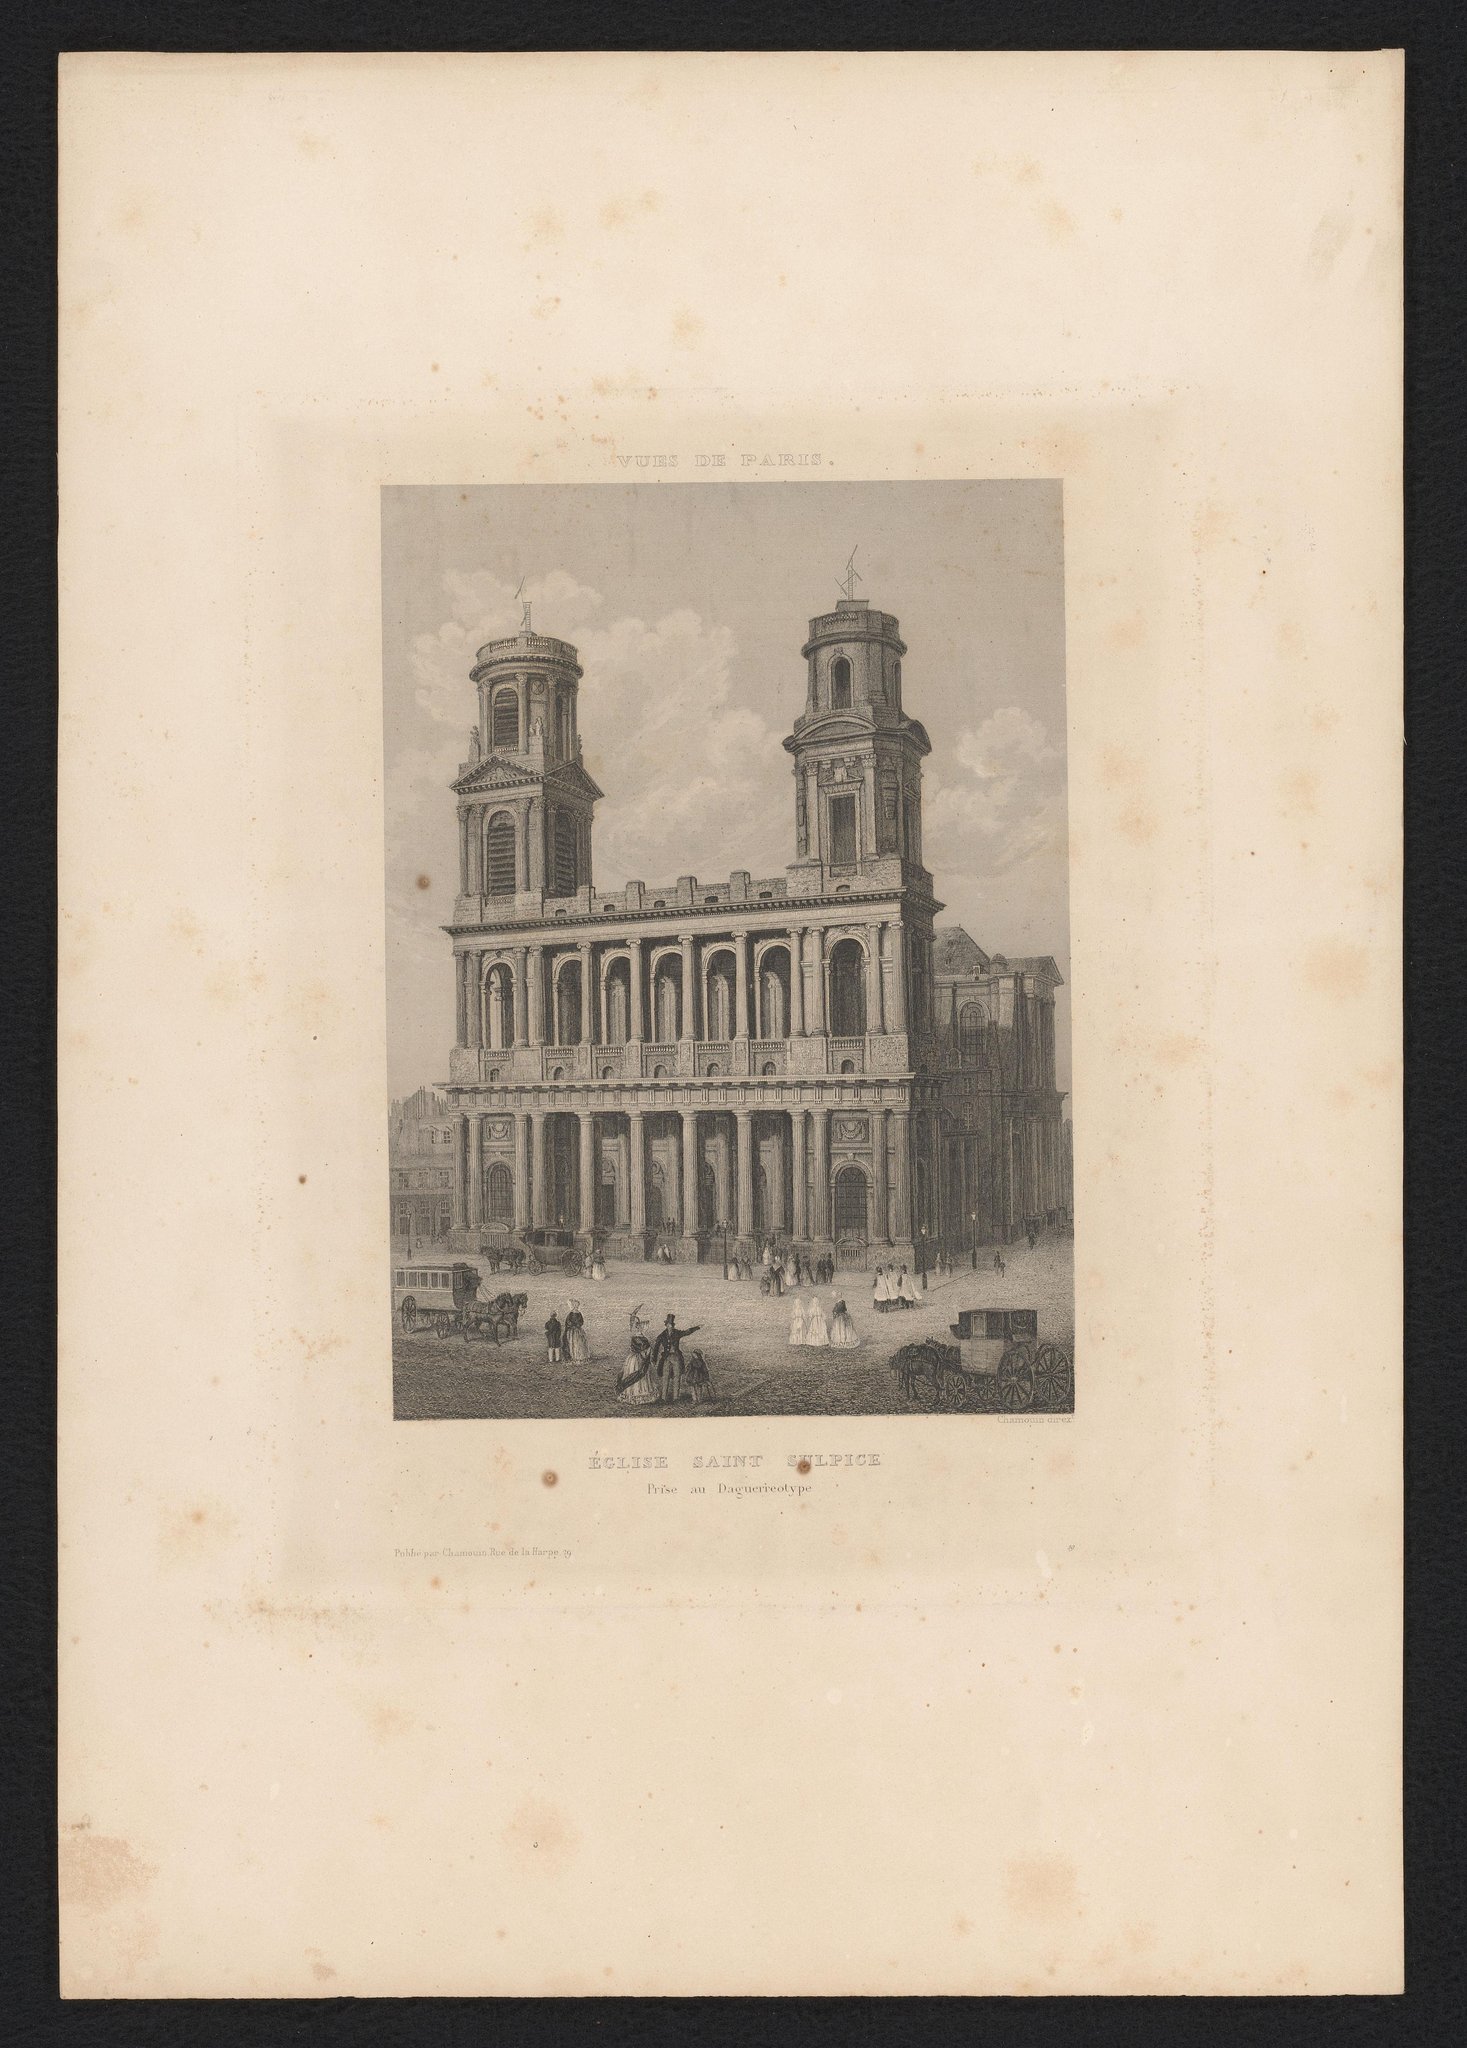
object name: print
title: Vues de Paris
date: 1845-1850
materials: paper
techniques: engraving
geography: paris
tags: church (exterior)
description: Deze prent maakt deel uit van een omslag met 22 prenten op 22 bladen.